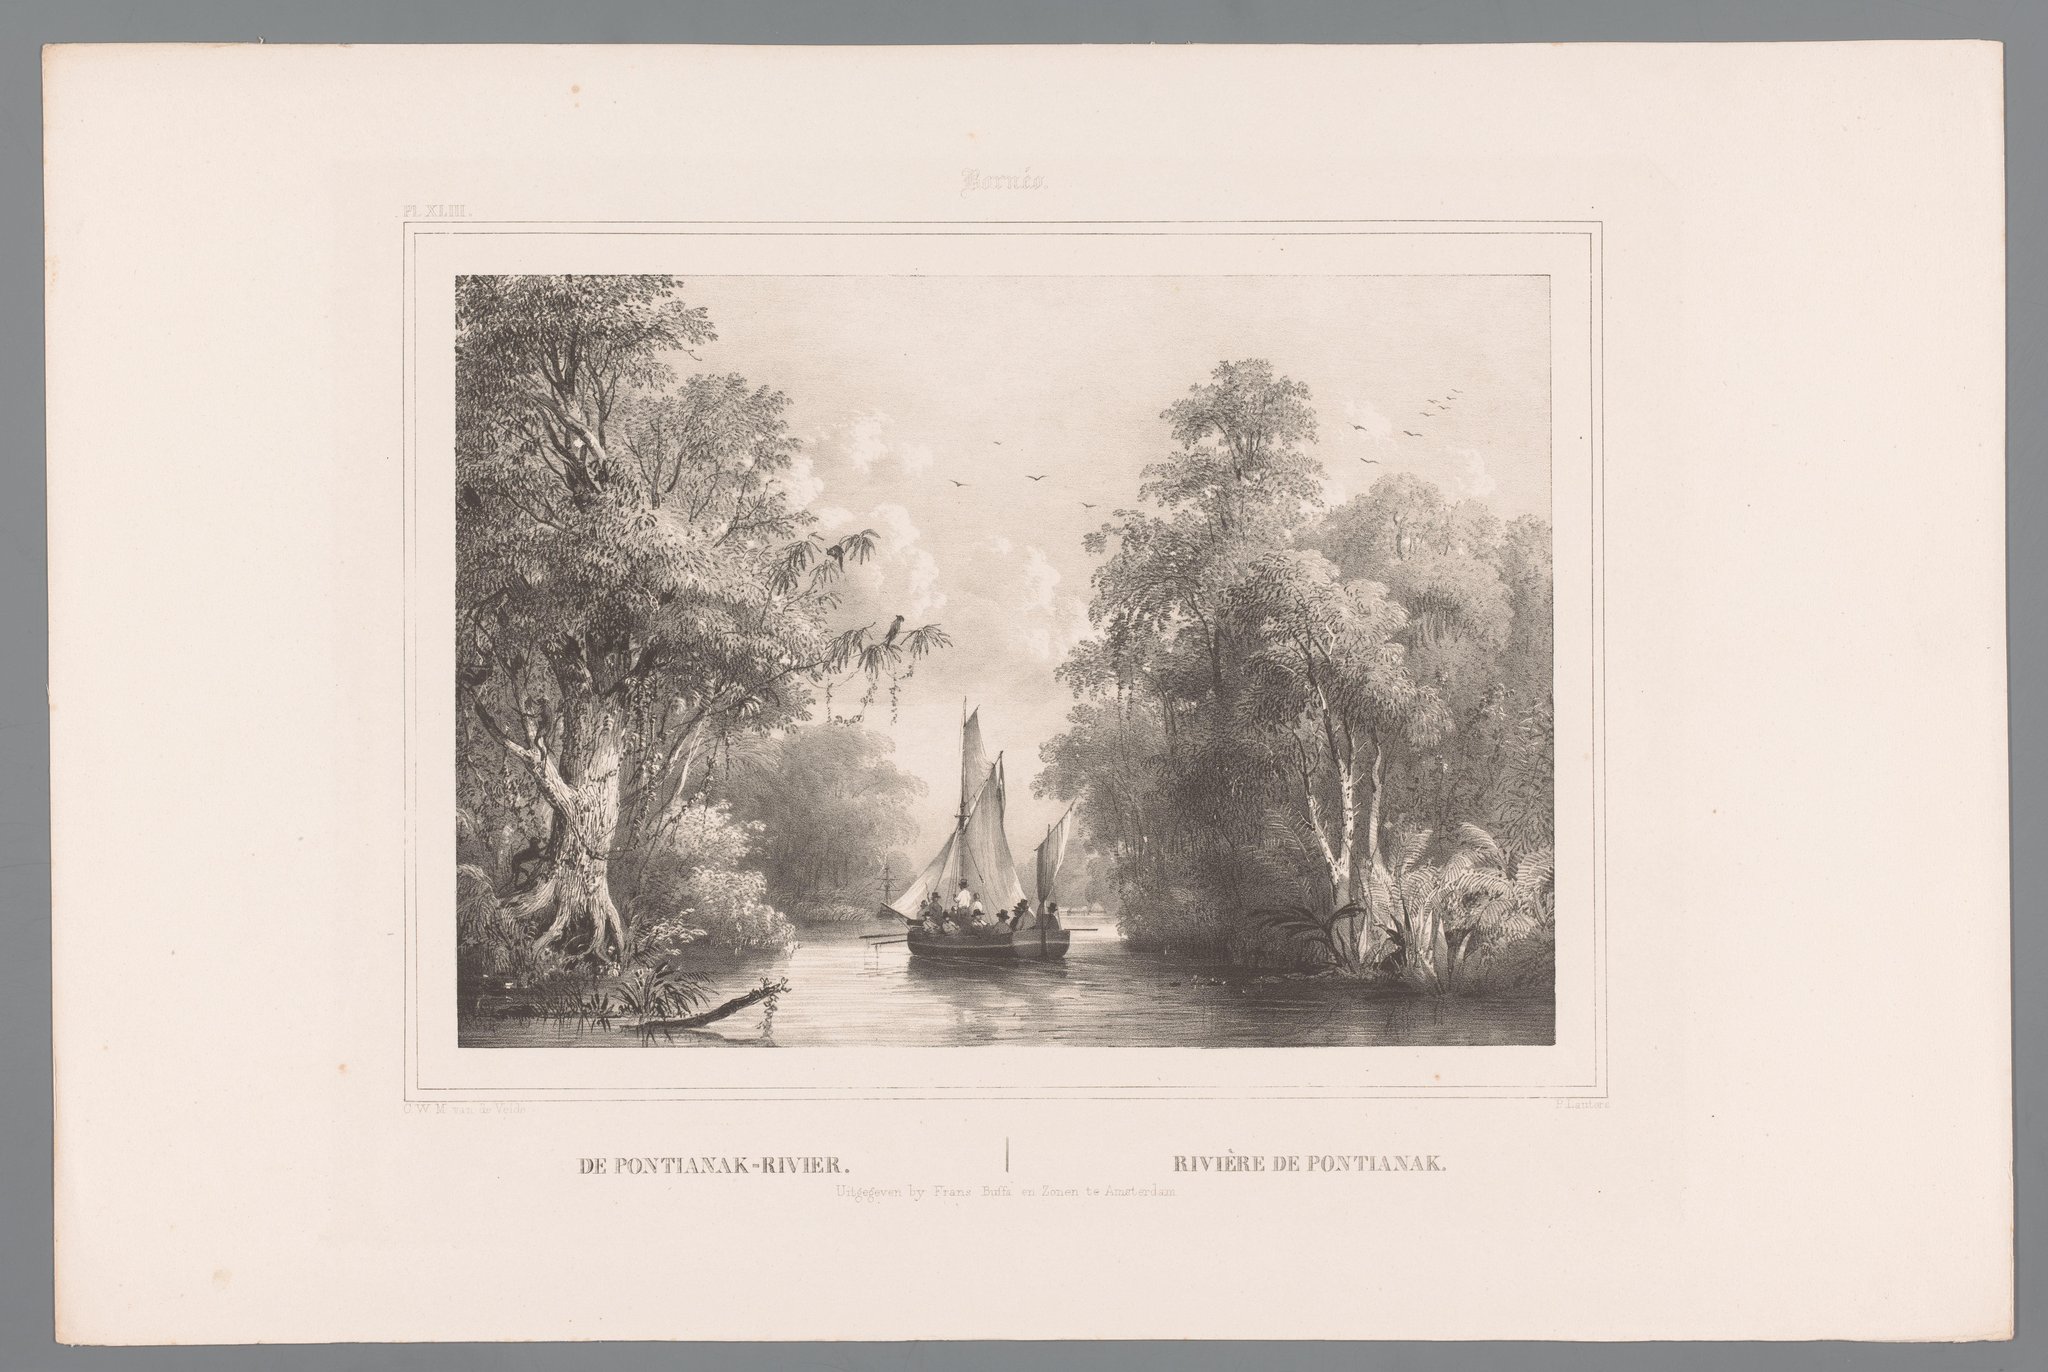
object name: print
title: Gezigten uit Neêrlands Indië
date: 1847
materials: paper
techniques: lithograph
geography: amsterdam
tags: sailing-ship, sailing-boat, river (+ landscape with figures, staffage)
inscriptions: collector's mark: Lugt 2228